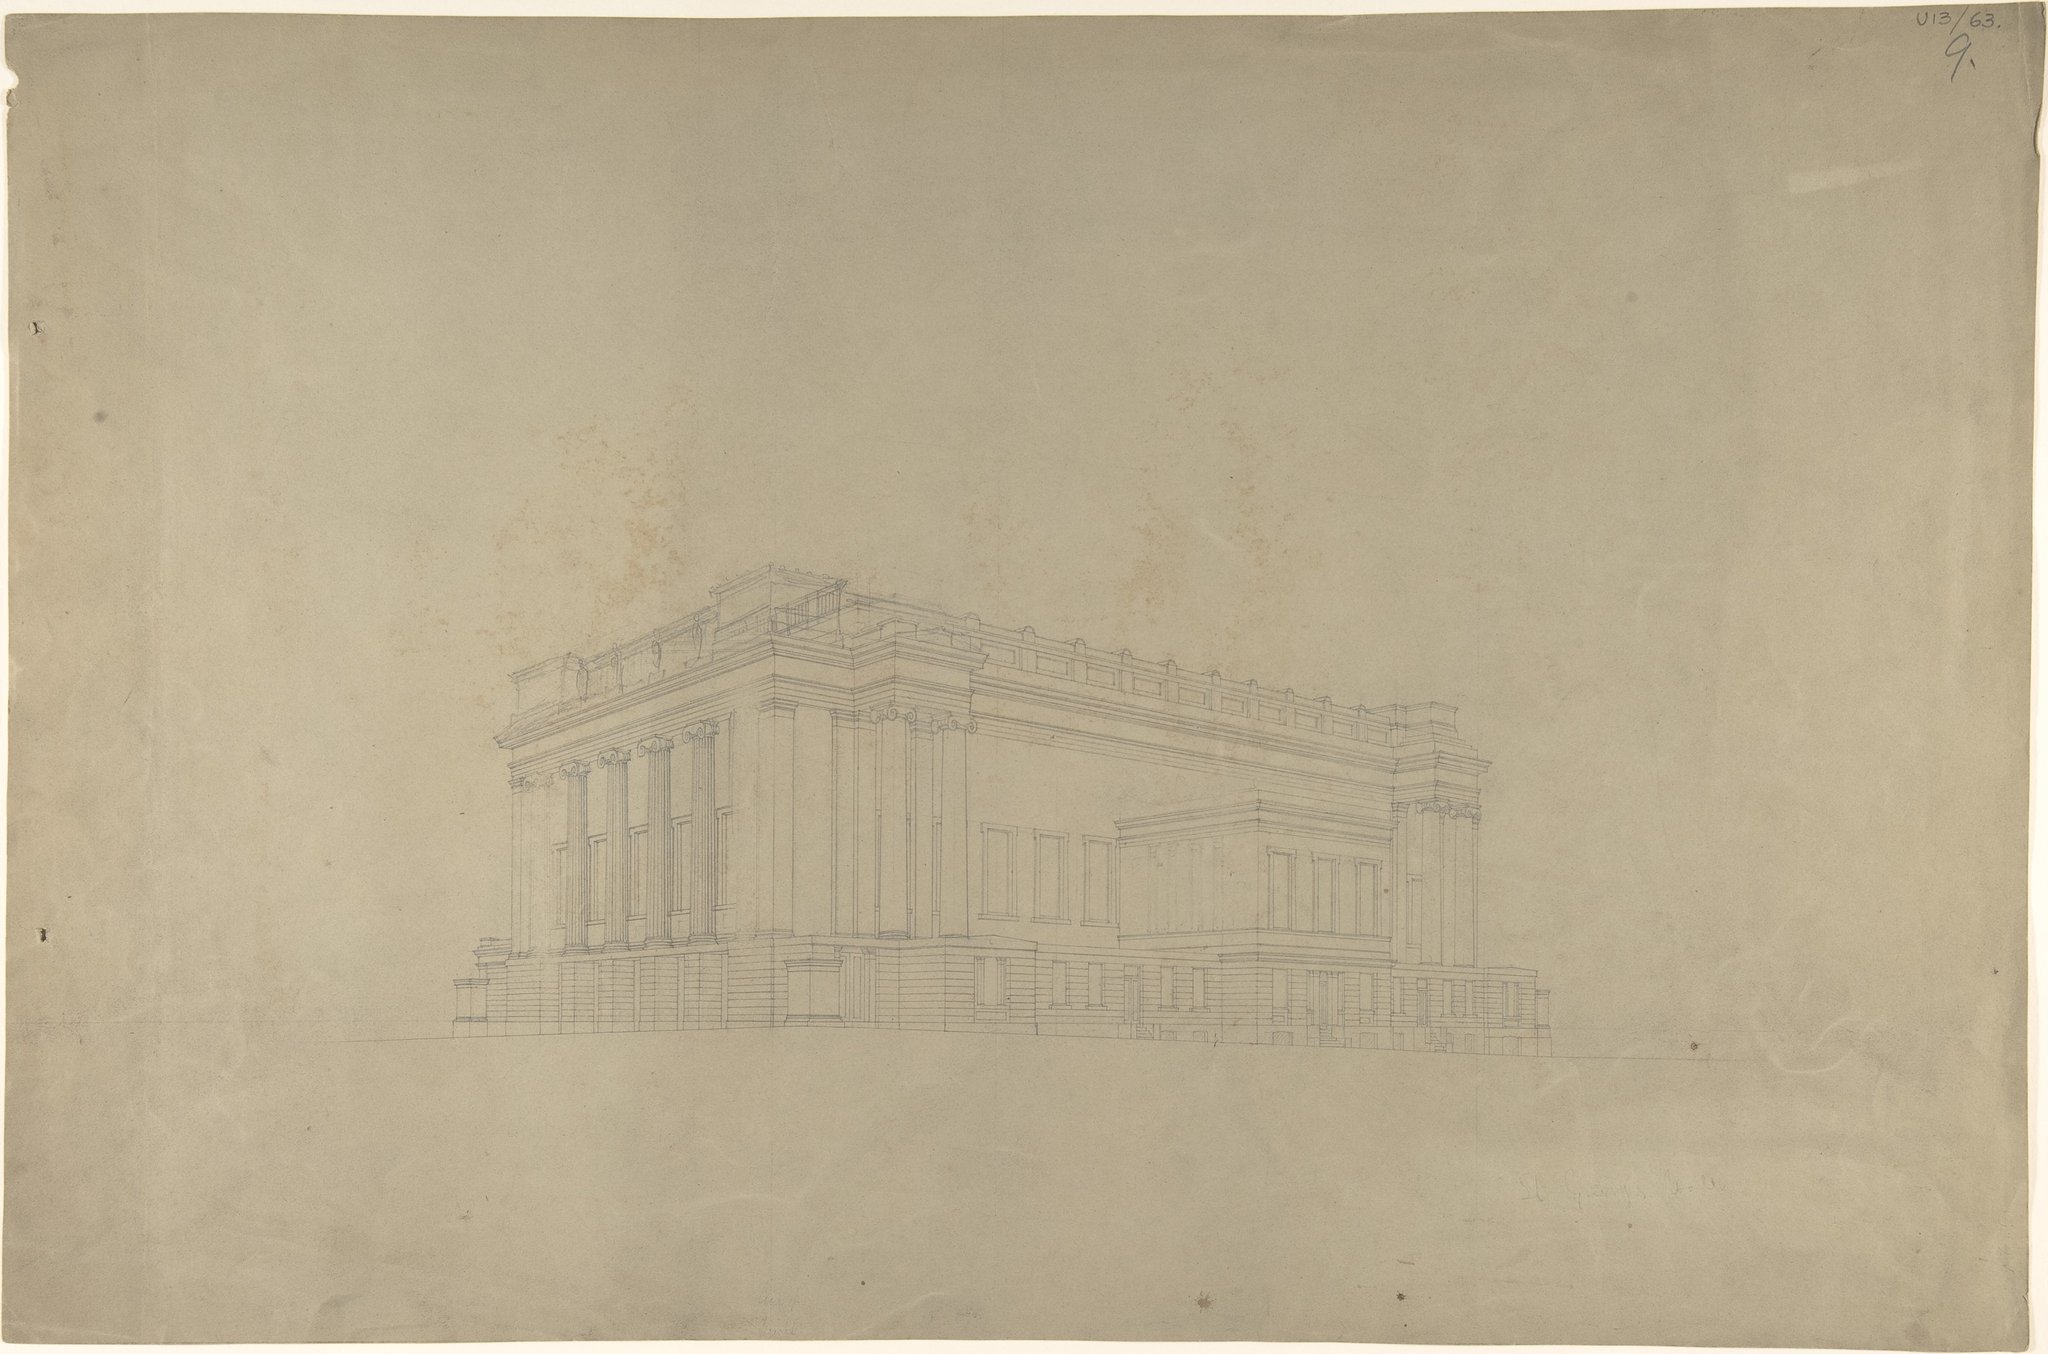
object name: drawing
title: View of a Building in the Ionic Style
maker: harvey lonsdale elmes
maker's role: artist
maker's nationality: british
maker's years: 1814-1847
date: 1830-1847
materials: graphite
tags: architecture,buildings